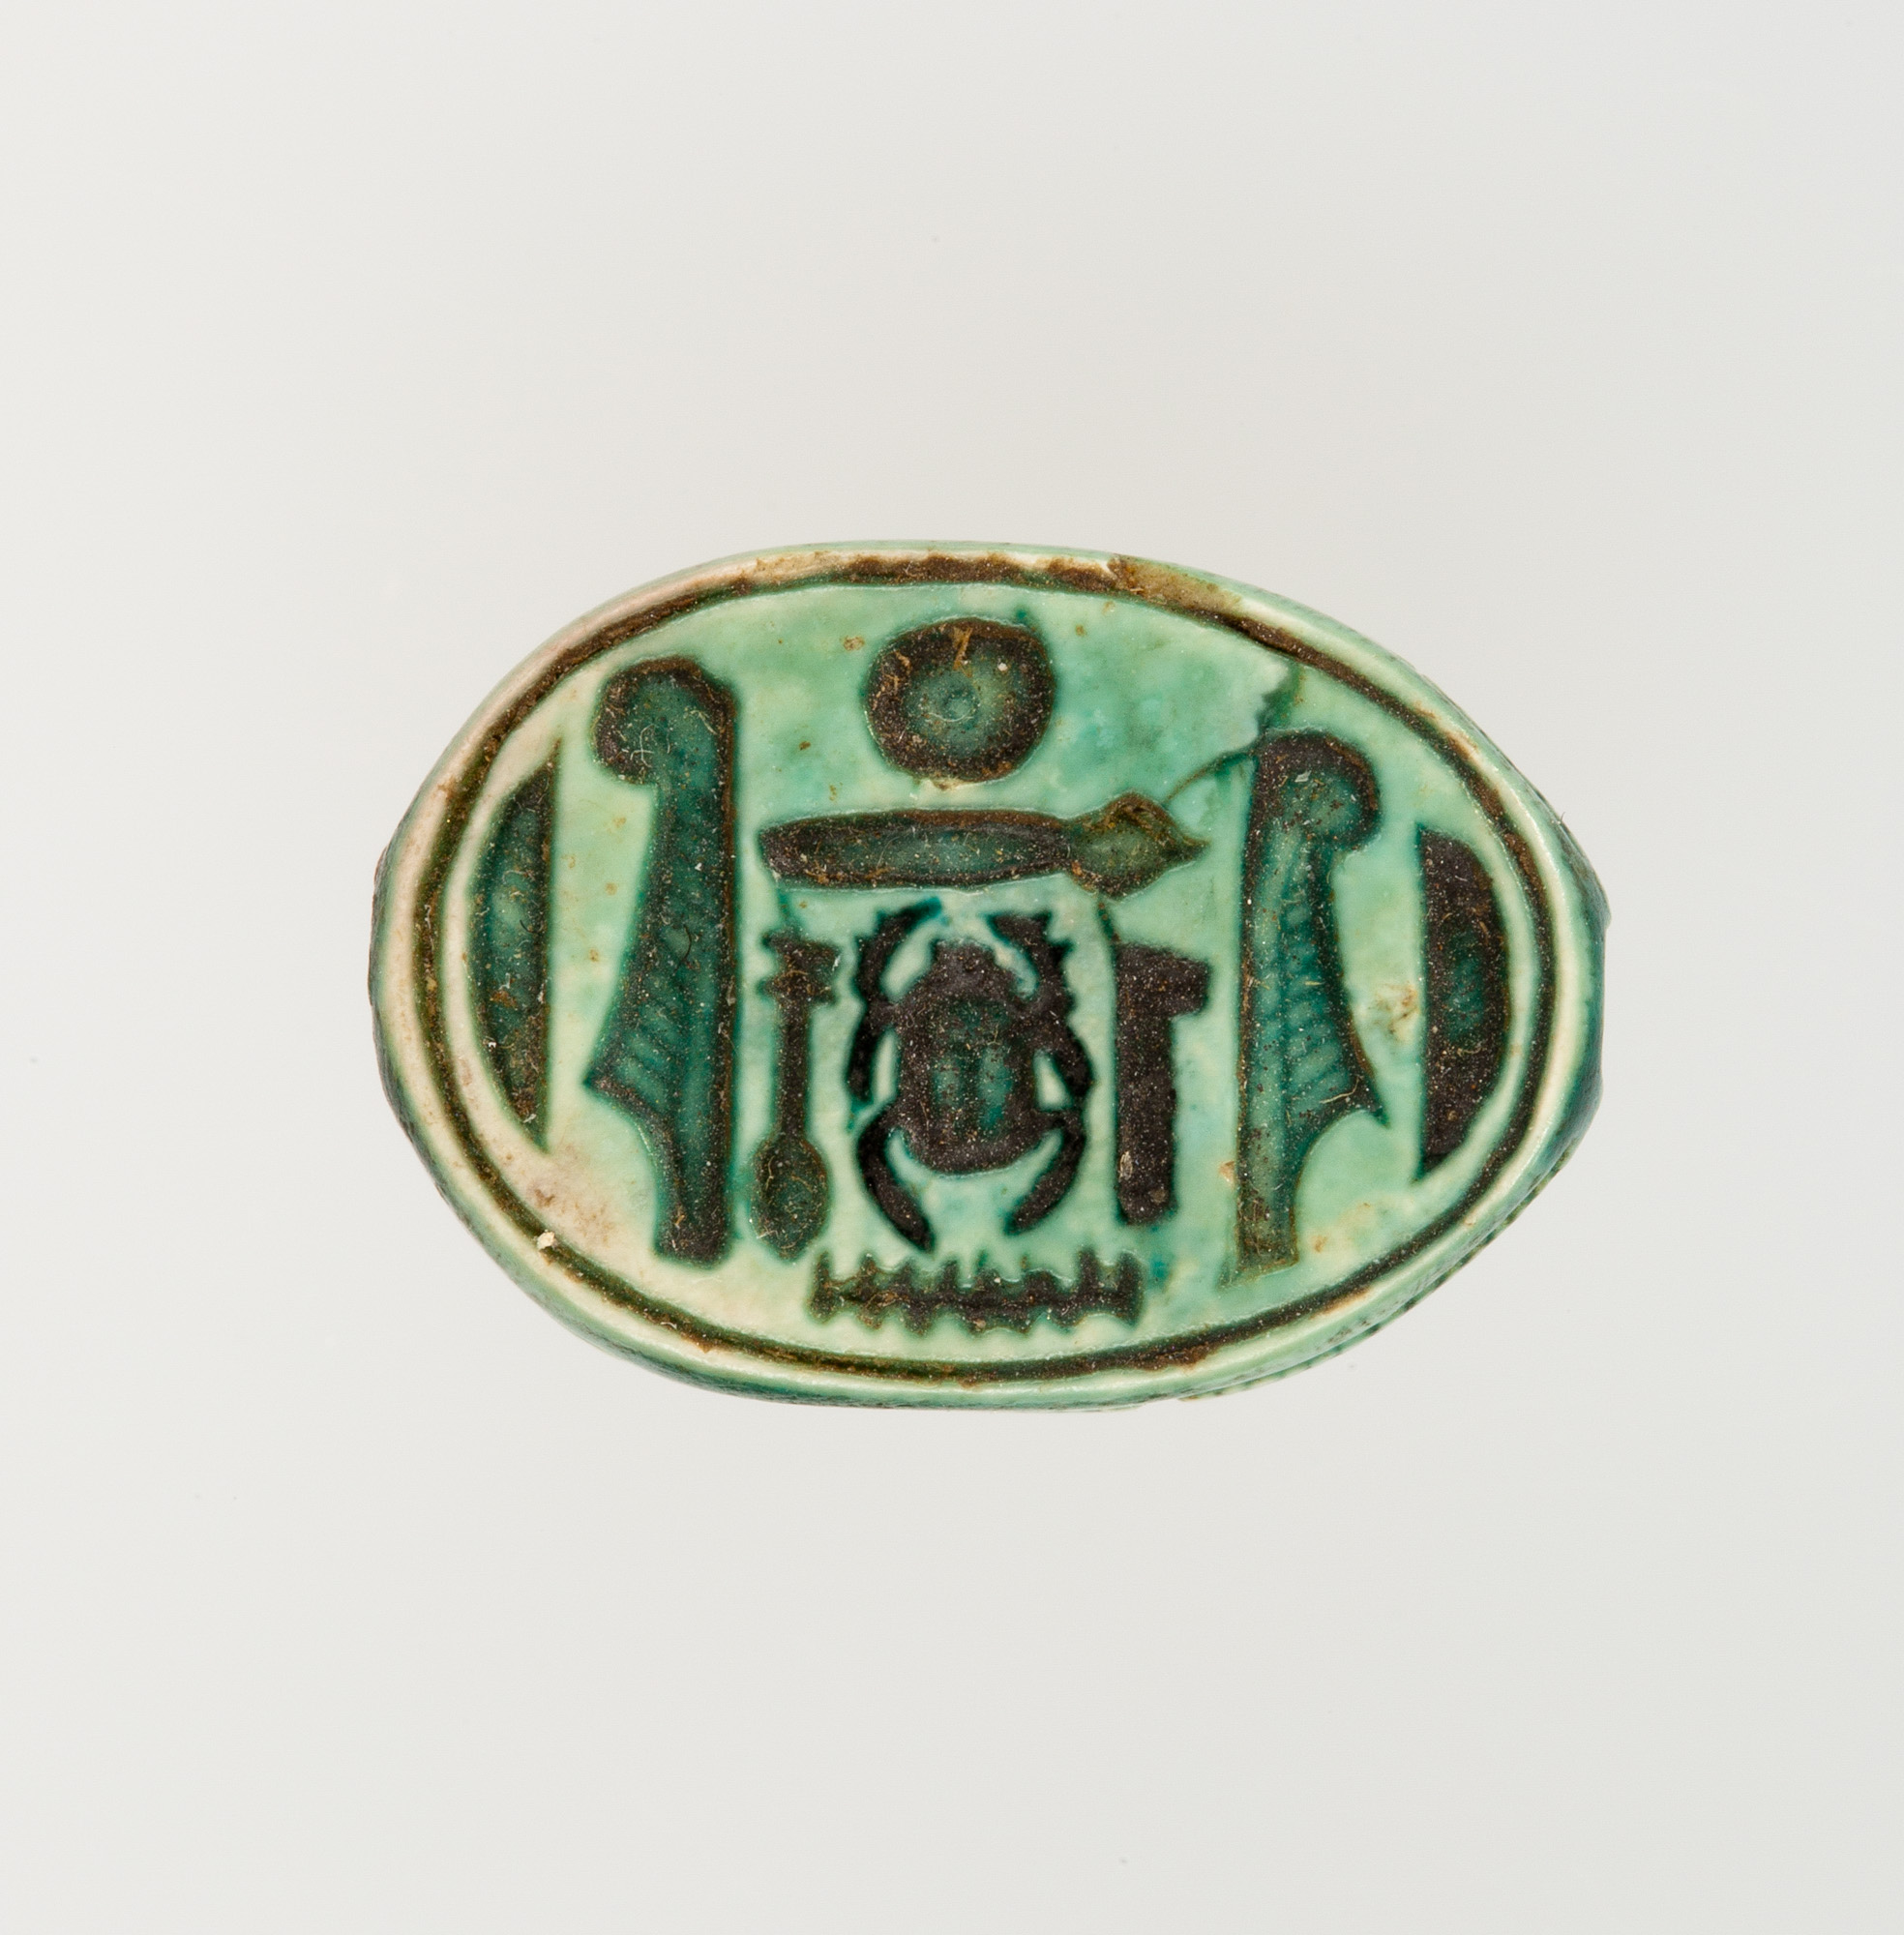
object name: scarab, thutmose ii, aakheperenre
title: Scarab Inscribed with the Throne Name of Thutmose II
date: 1504-1492 BCE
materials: stone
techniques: glazing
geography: egypt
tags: hieroglyphs,scarabs